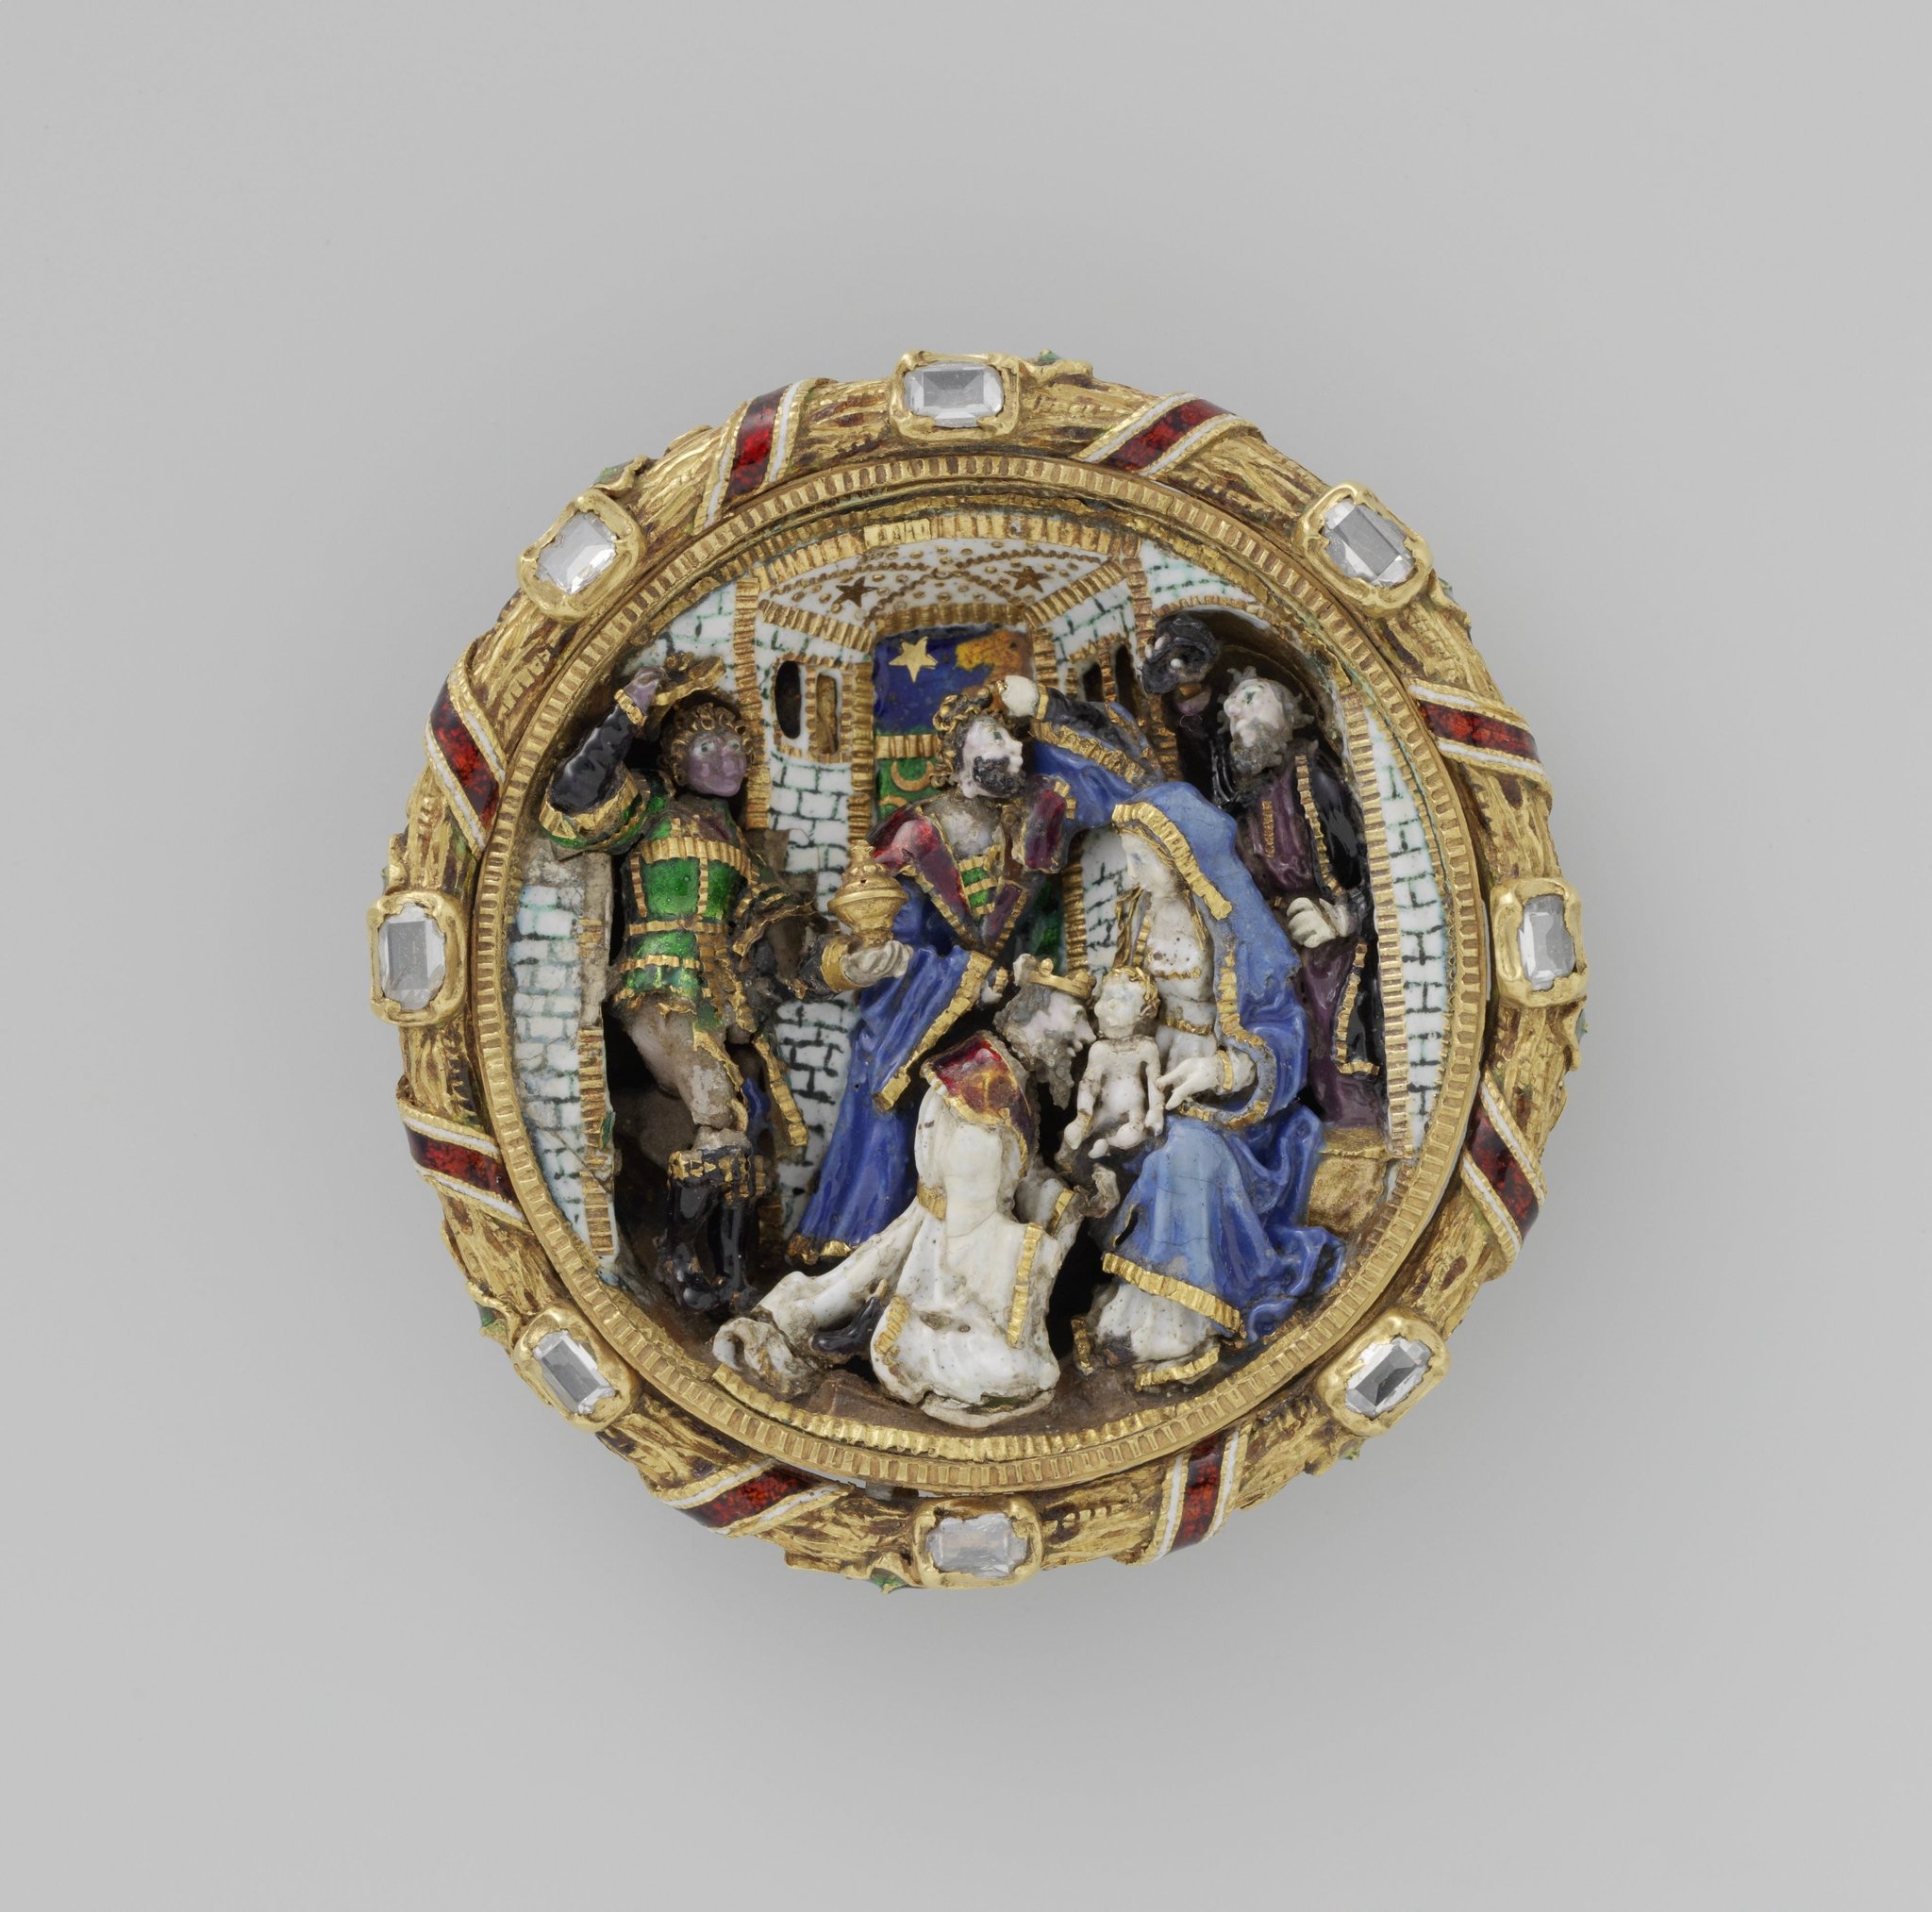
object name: locket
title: Medallion with the Adoration of the Magi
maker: Anonymous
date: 1450-1500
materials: diamond, gold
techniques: enameling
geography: southern netherlands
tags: adoration of the kings: the wise men present their gifts to the christ-child (gold, frankincense and myrrh)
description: An entire story unfolds in 3D inside this concave stage setting. The scene is cast in gold. Its colouration is the result of a complex process: every colour of enamel has its own melting point and so a separate firing is required for each tint. This jewel bears a resemblance to wooden prayer nuts, but they were made only some fifty years later.